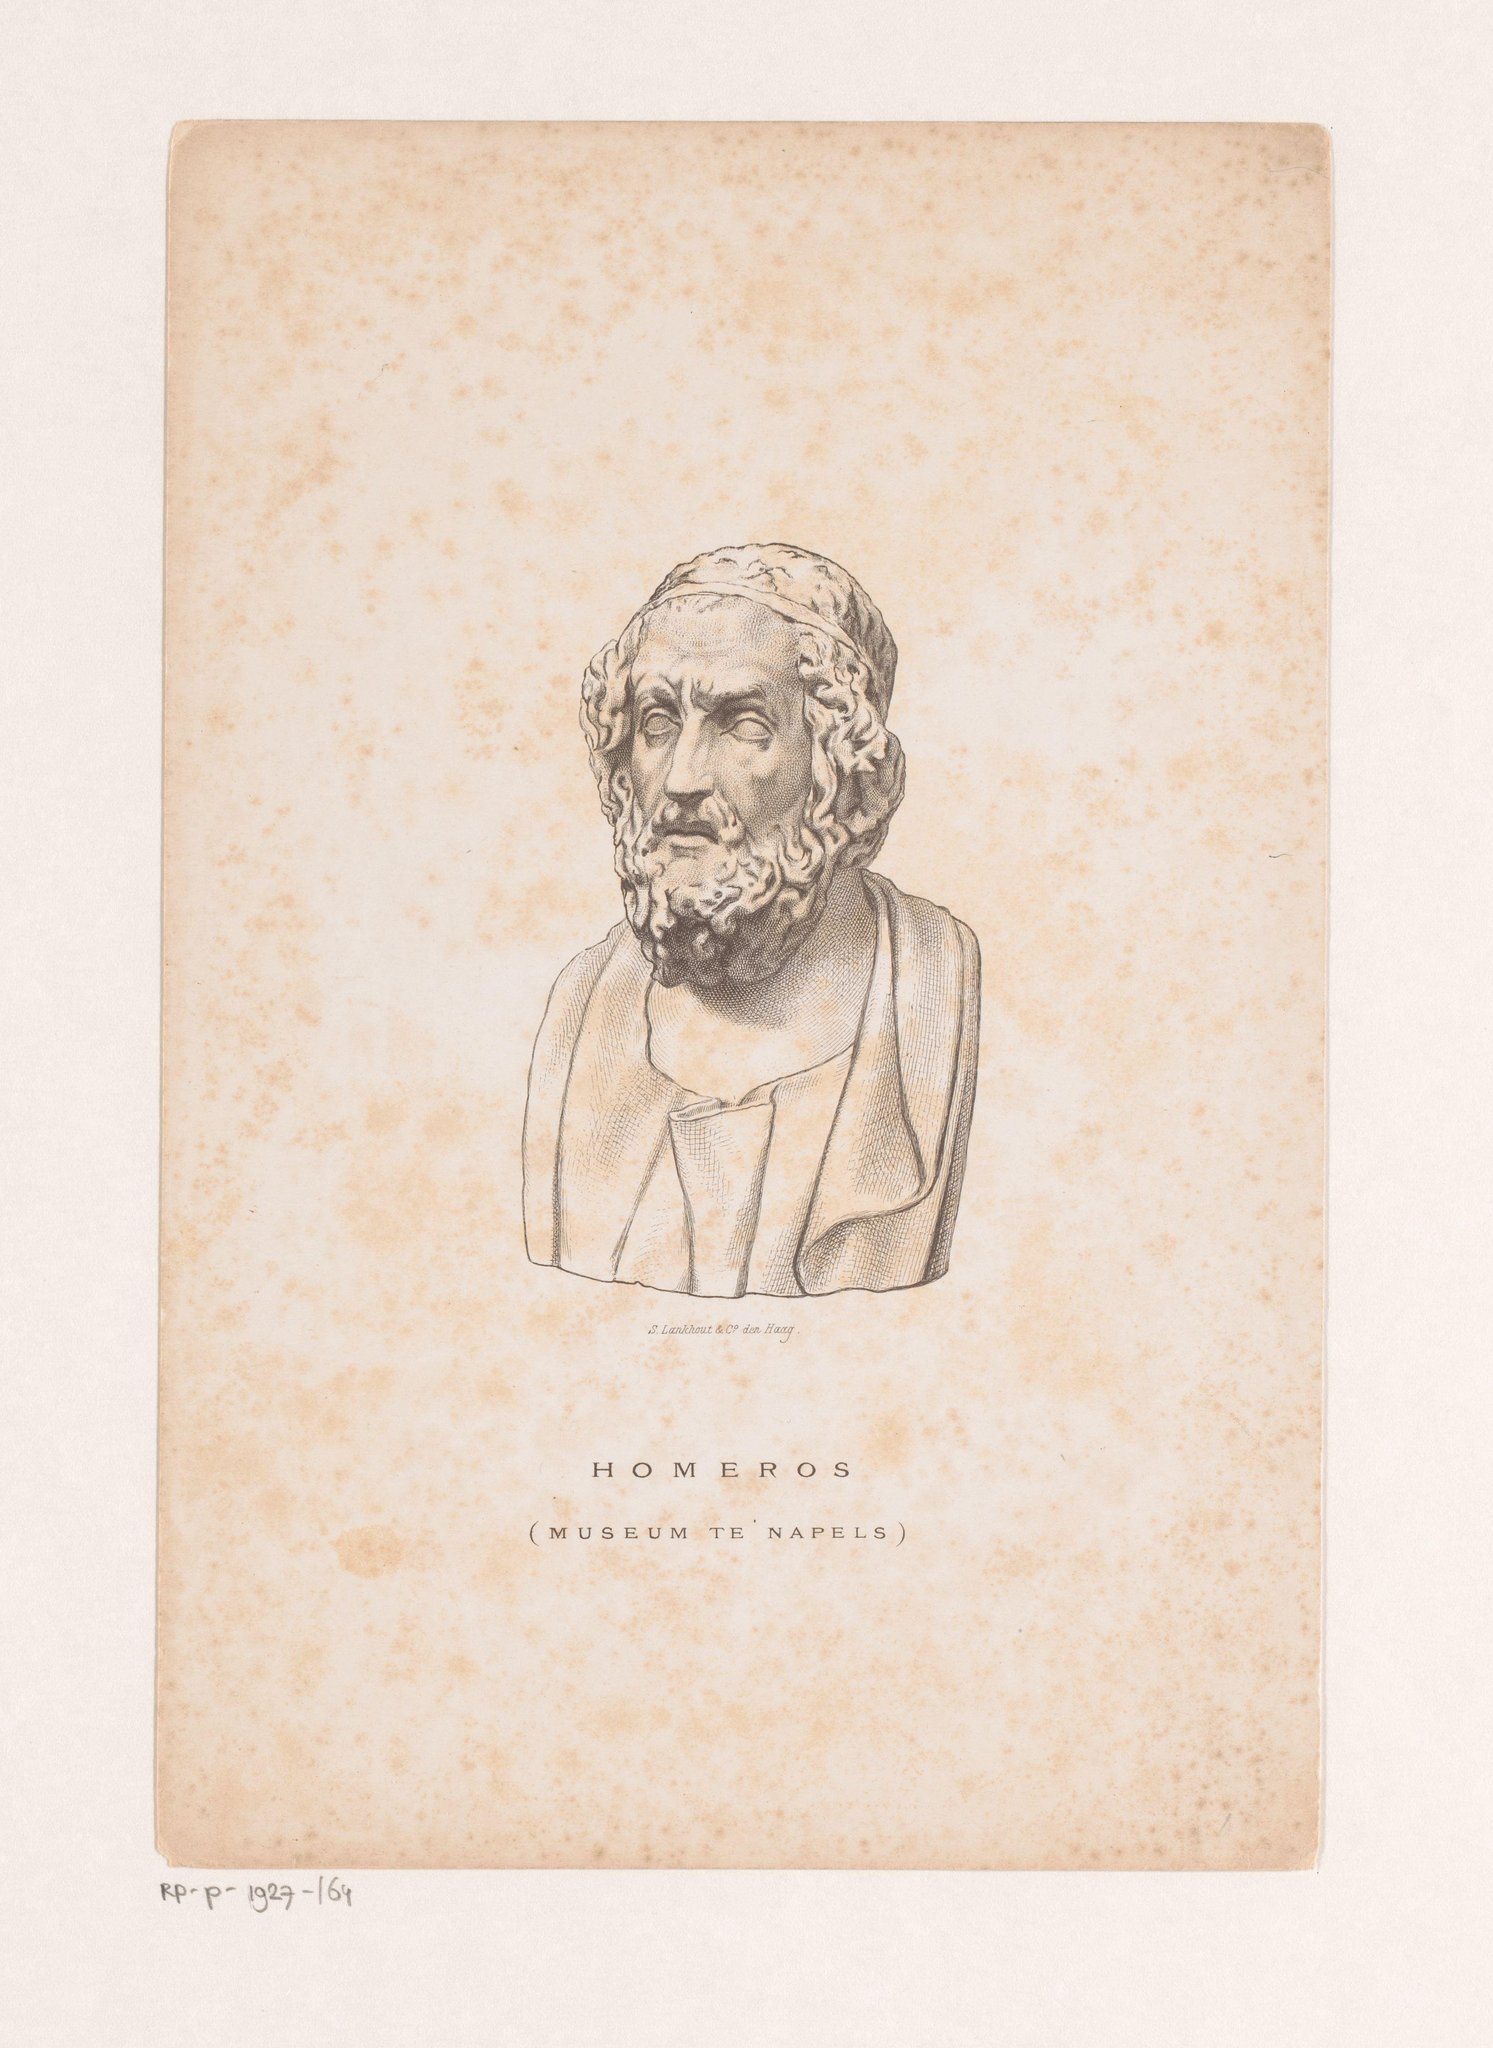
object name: print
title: Homeros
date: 1877-1903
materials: paper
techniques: lithograph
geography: the hague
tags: portrait of homer (+ head, bust, etc.)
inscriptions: collector's mark: Lugt 2233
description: De buste van Homerus bevindt zich in het Nationaal Archeologisch Museum in Napels. Maakte waarschijnlijk deel uit van een serie, zie RP-P-1927-164, RP-P-1927-165 en RP-P-1927-166.